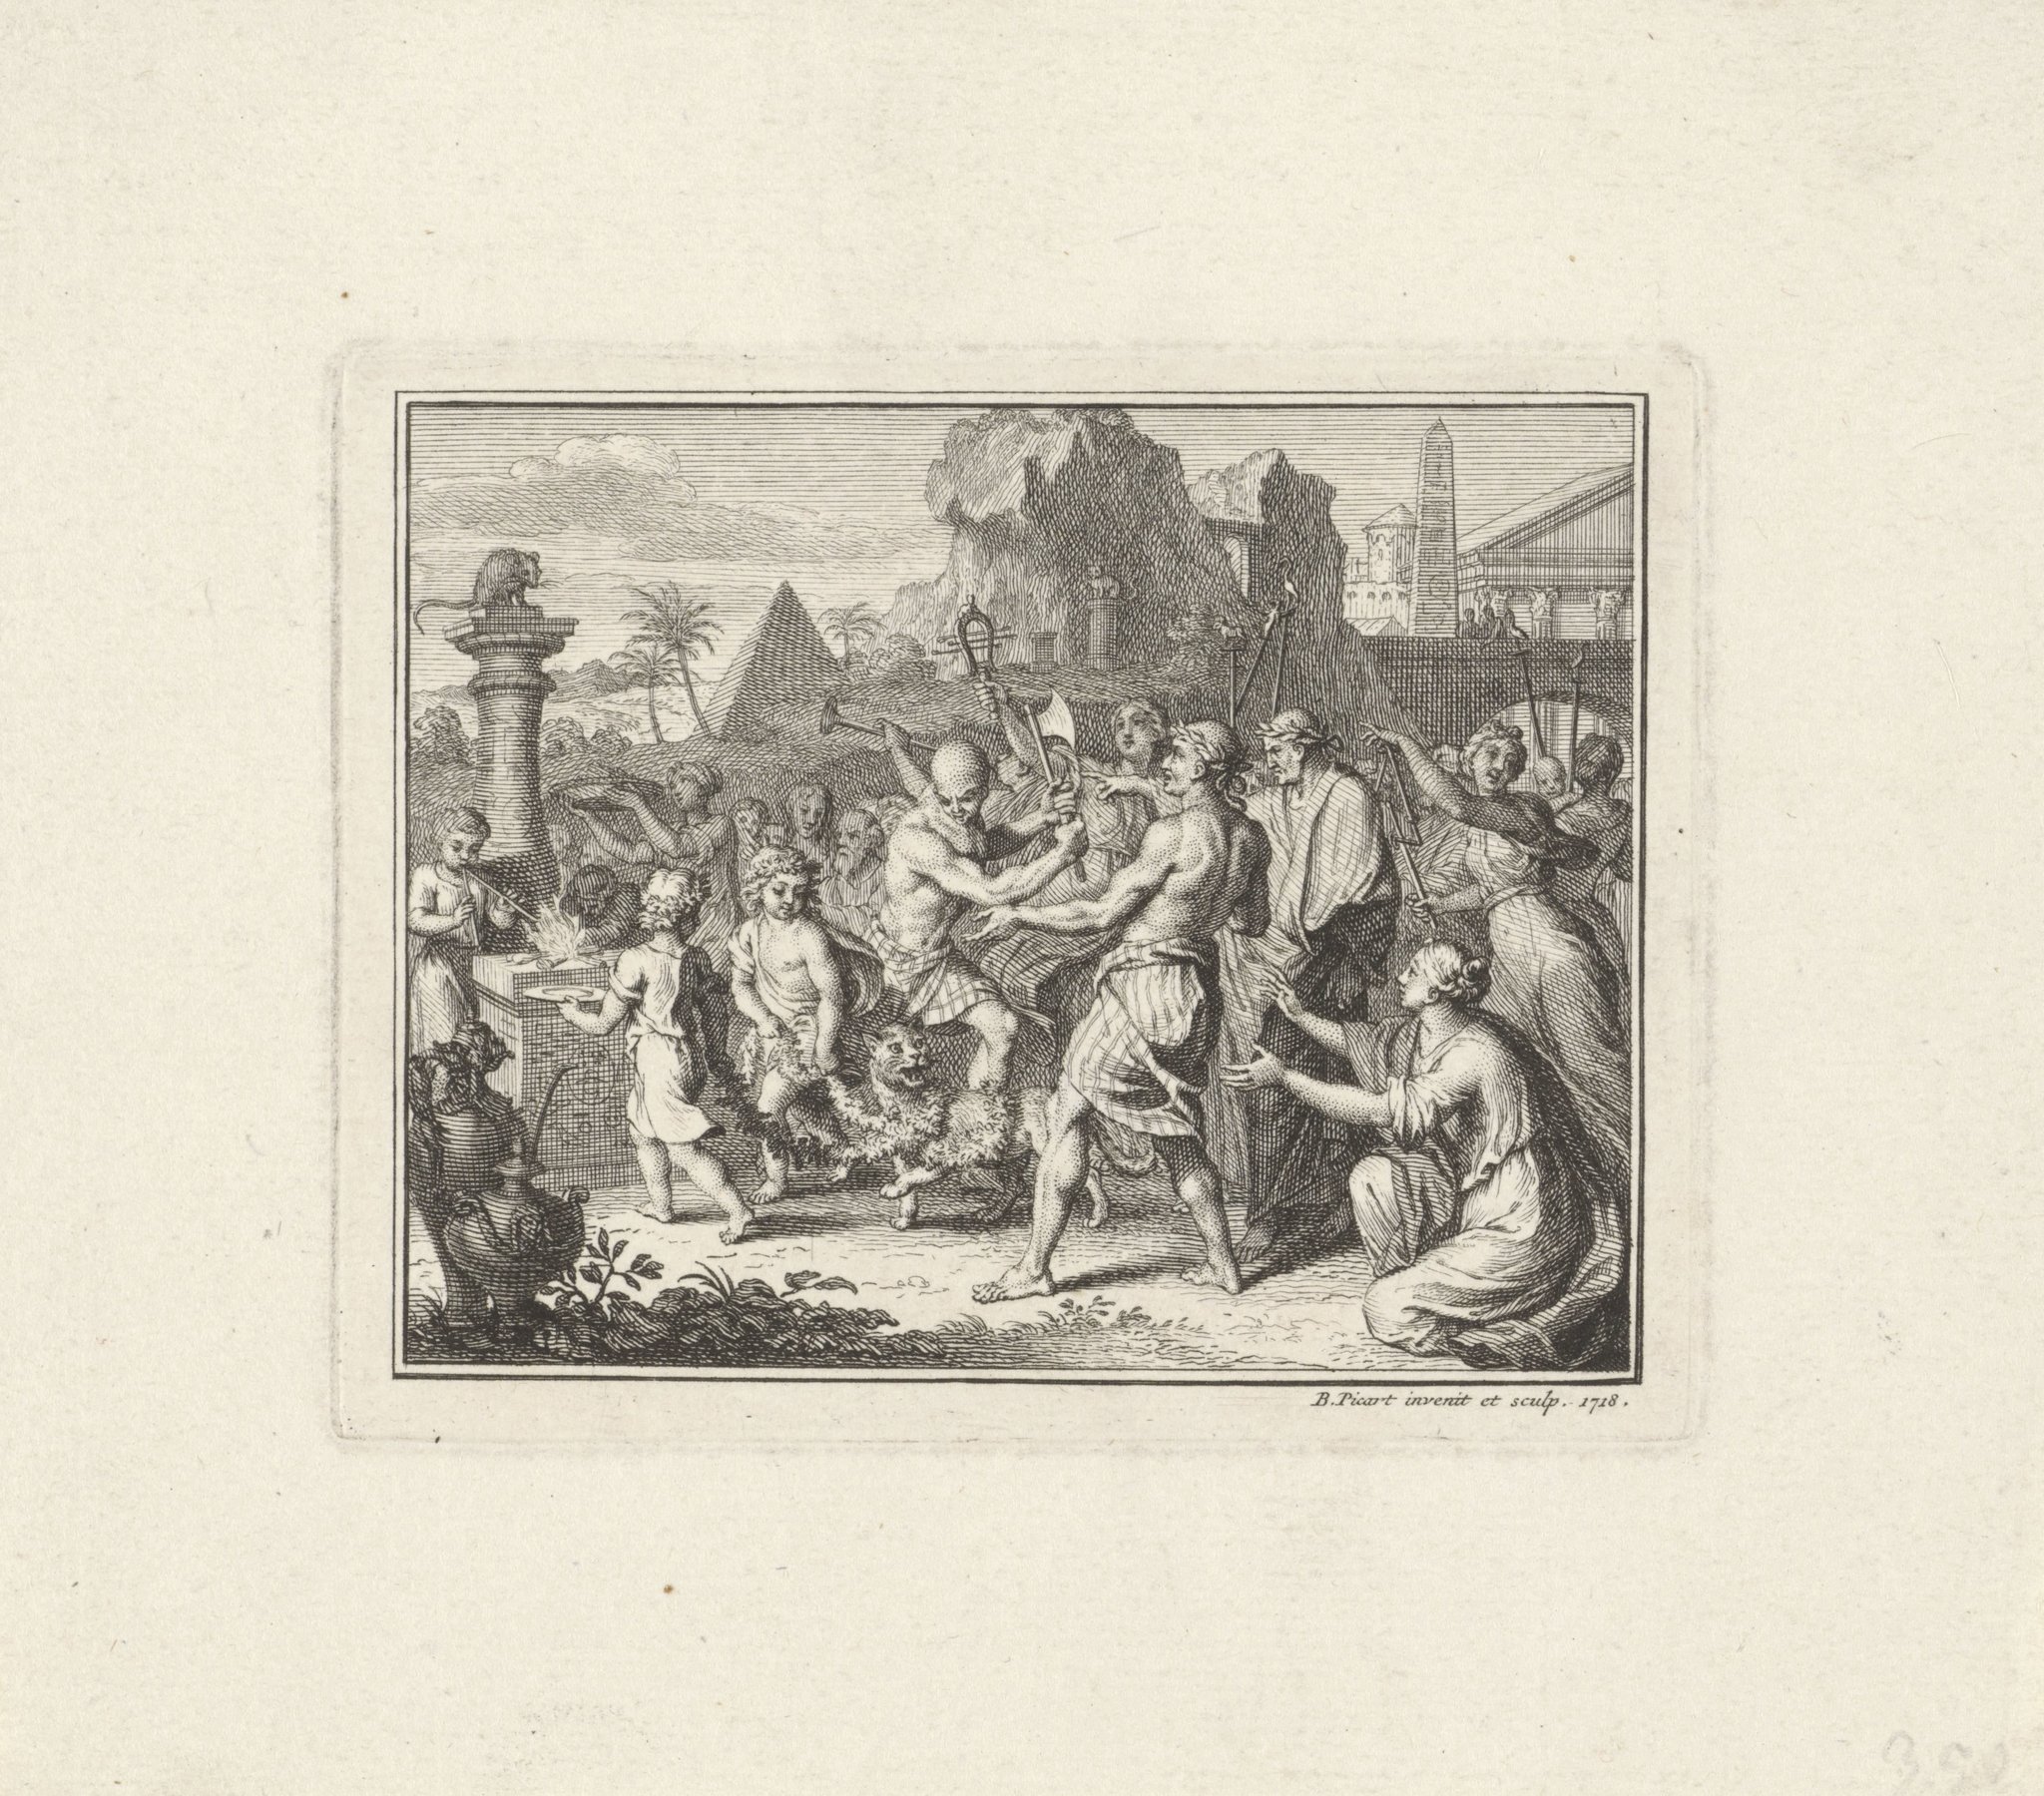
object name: print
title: Offeren van een kat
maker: bernard picart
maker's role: draughtsman, print maker, publisher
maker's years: 1673-1733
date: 1718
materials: paper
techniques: engraving, etching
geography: amsterdam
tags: cat, sacrifice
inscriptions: collector's mark: Lugt 2228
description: Optocht in Egypte met een kat, die naar een altaar wordt geleid.